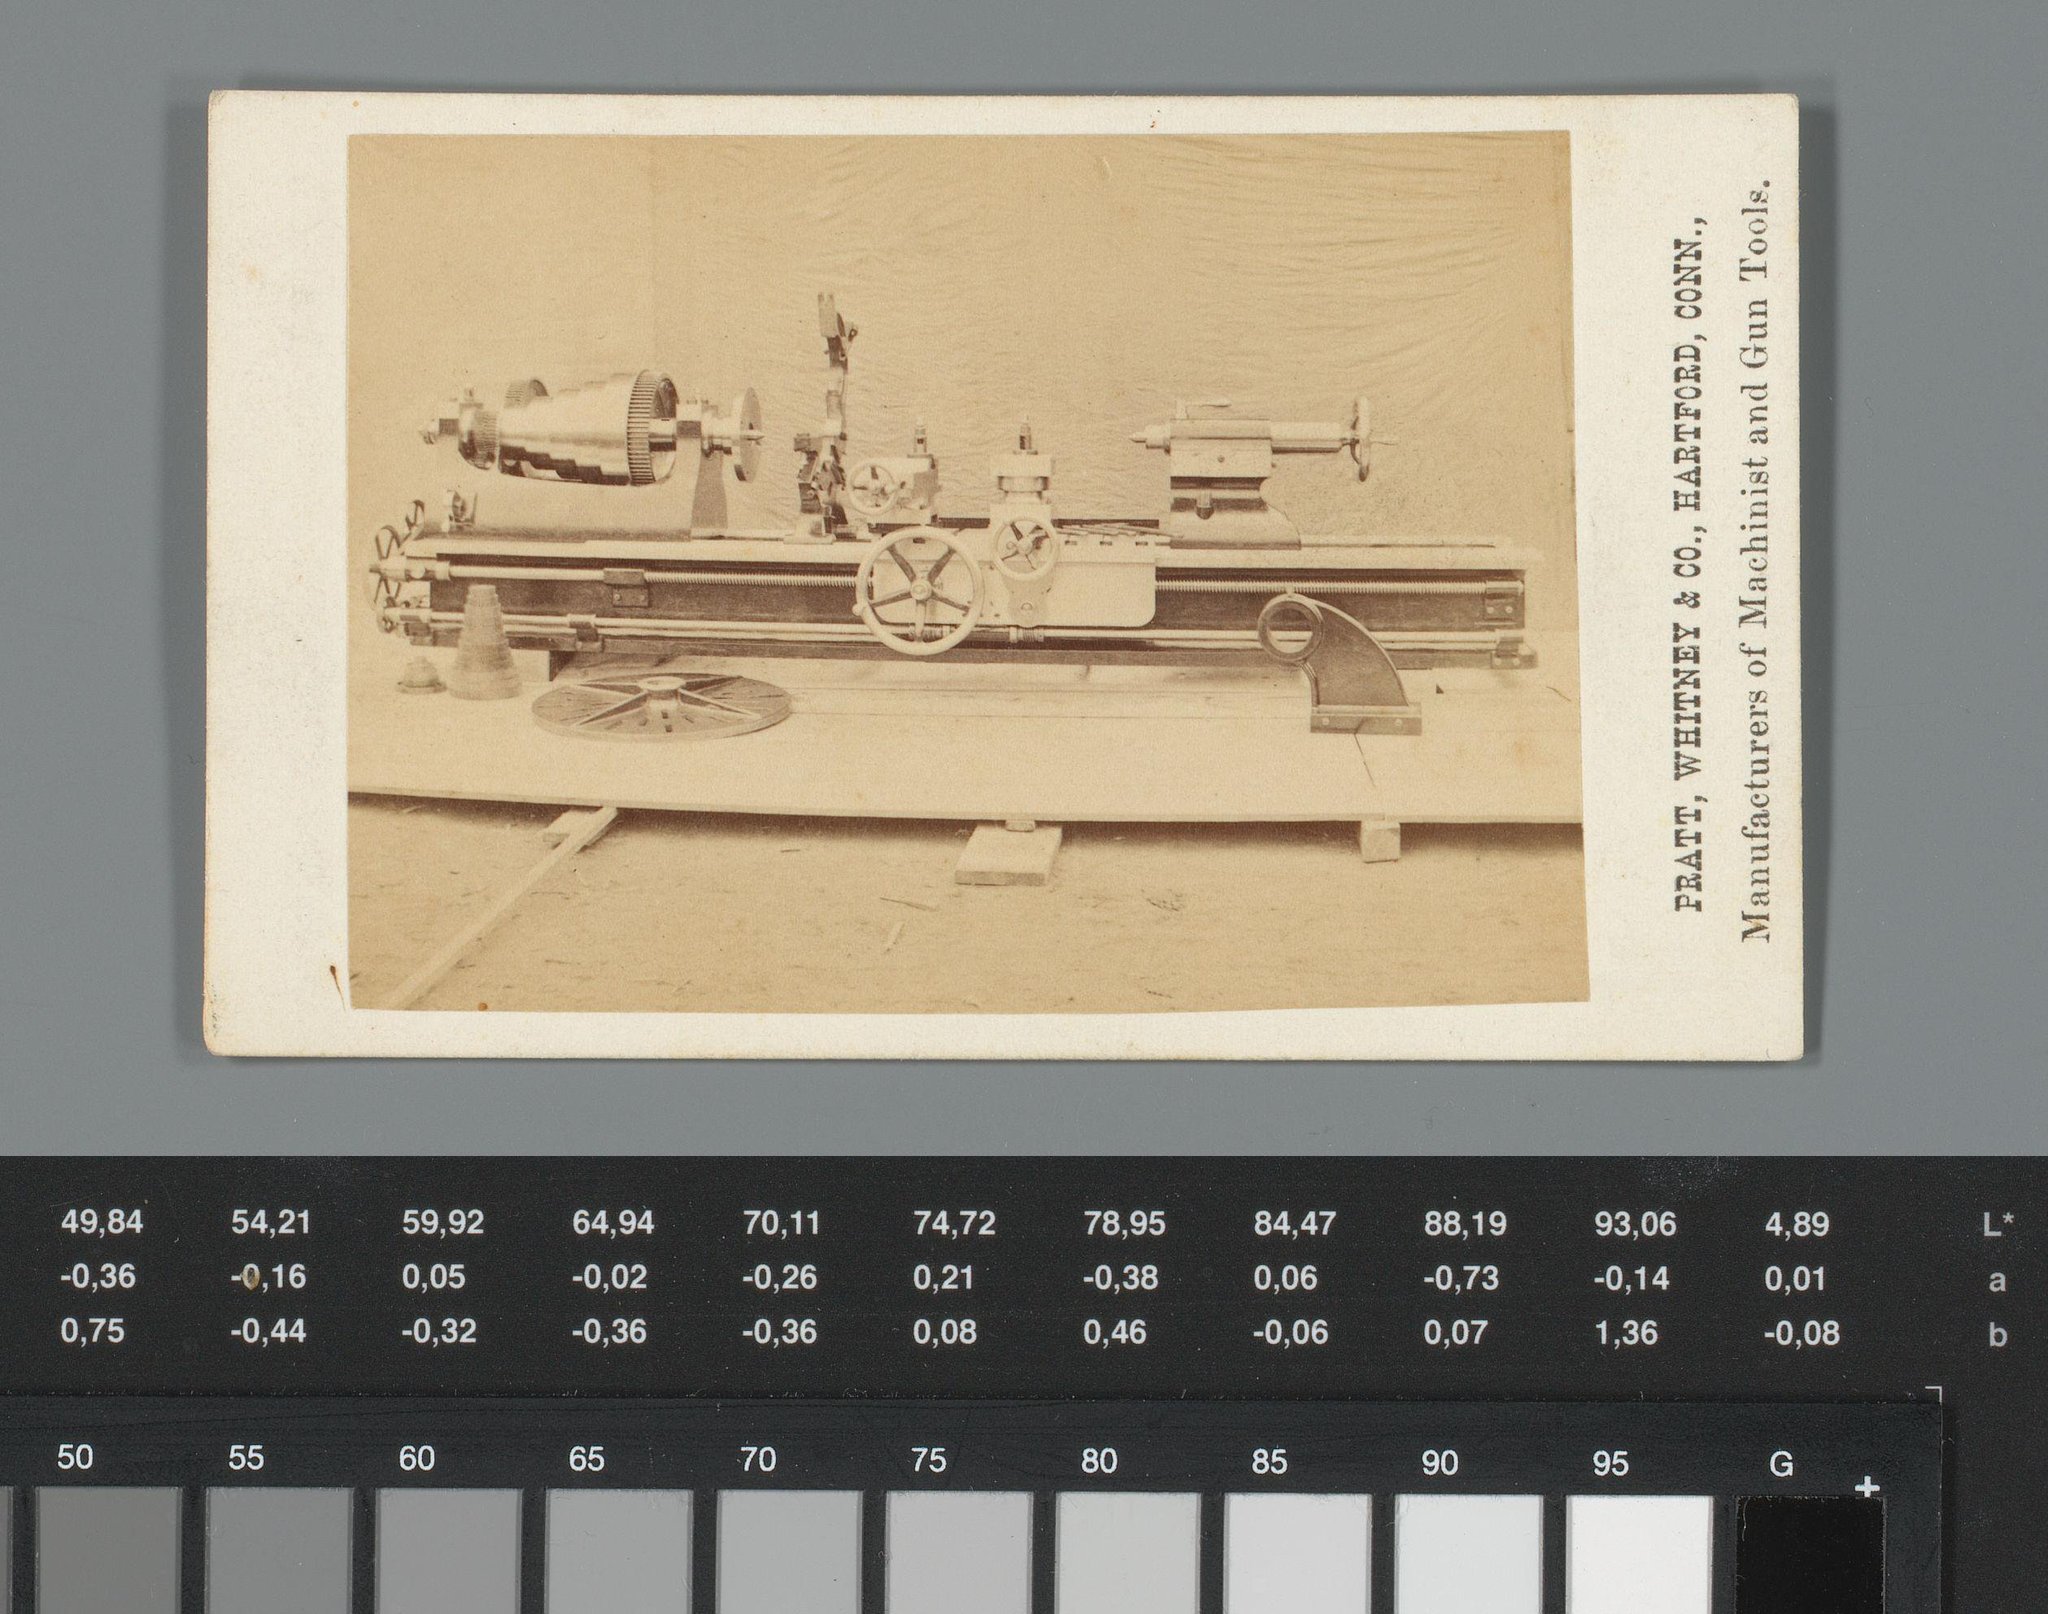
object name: photograph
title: Reclame voor een draaibank van Pratt, Whitney & Company in Hartford, Connecticut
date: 1850-1915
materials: cardboard, photographic support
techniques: albumen print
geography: hartford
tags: advertising, machines; parts of machines; tools and appliances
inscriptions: inscription: ‘(...)/ Prescott & White,/ No. 368 Main Street,/ Hartford, Conn../ (...)’